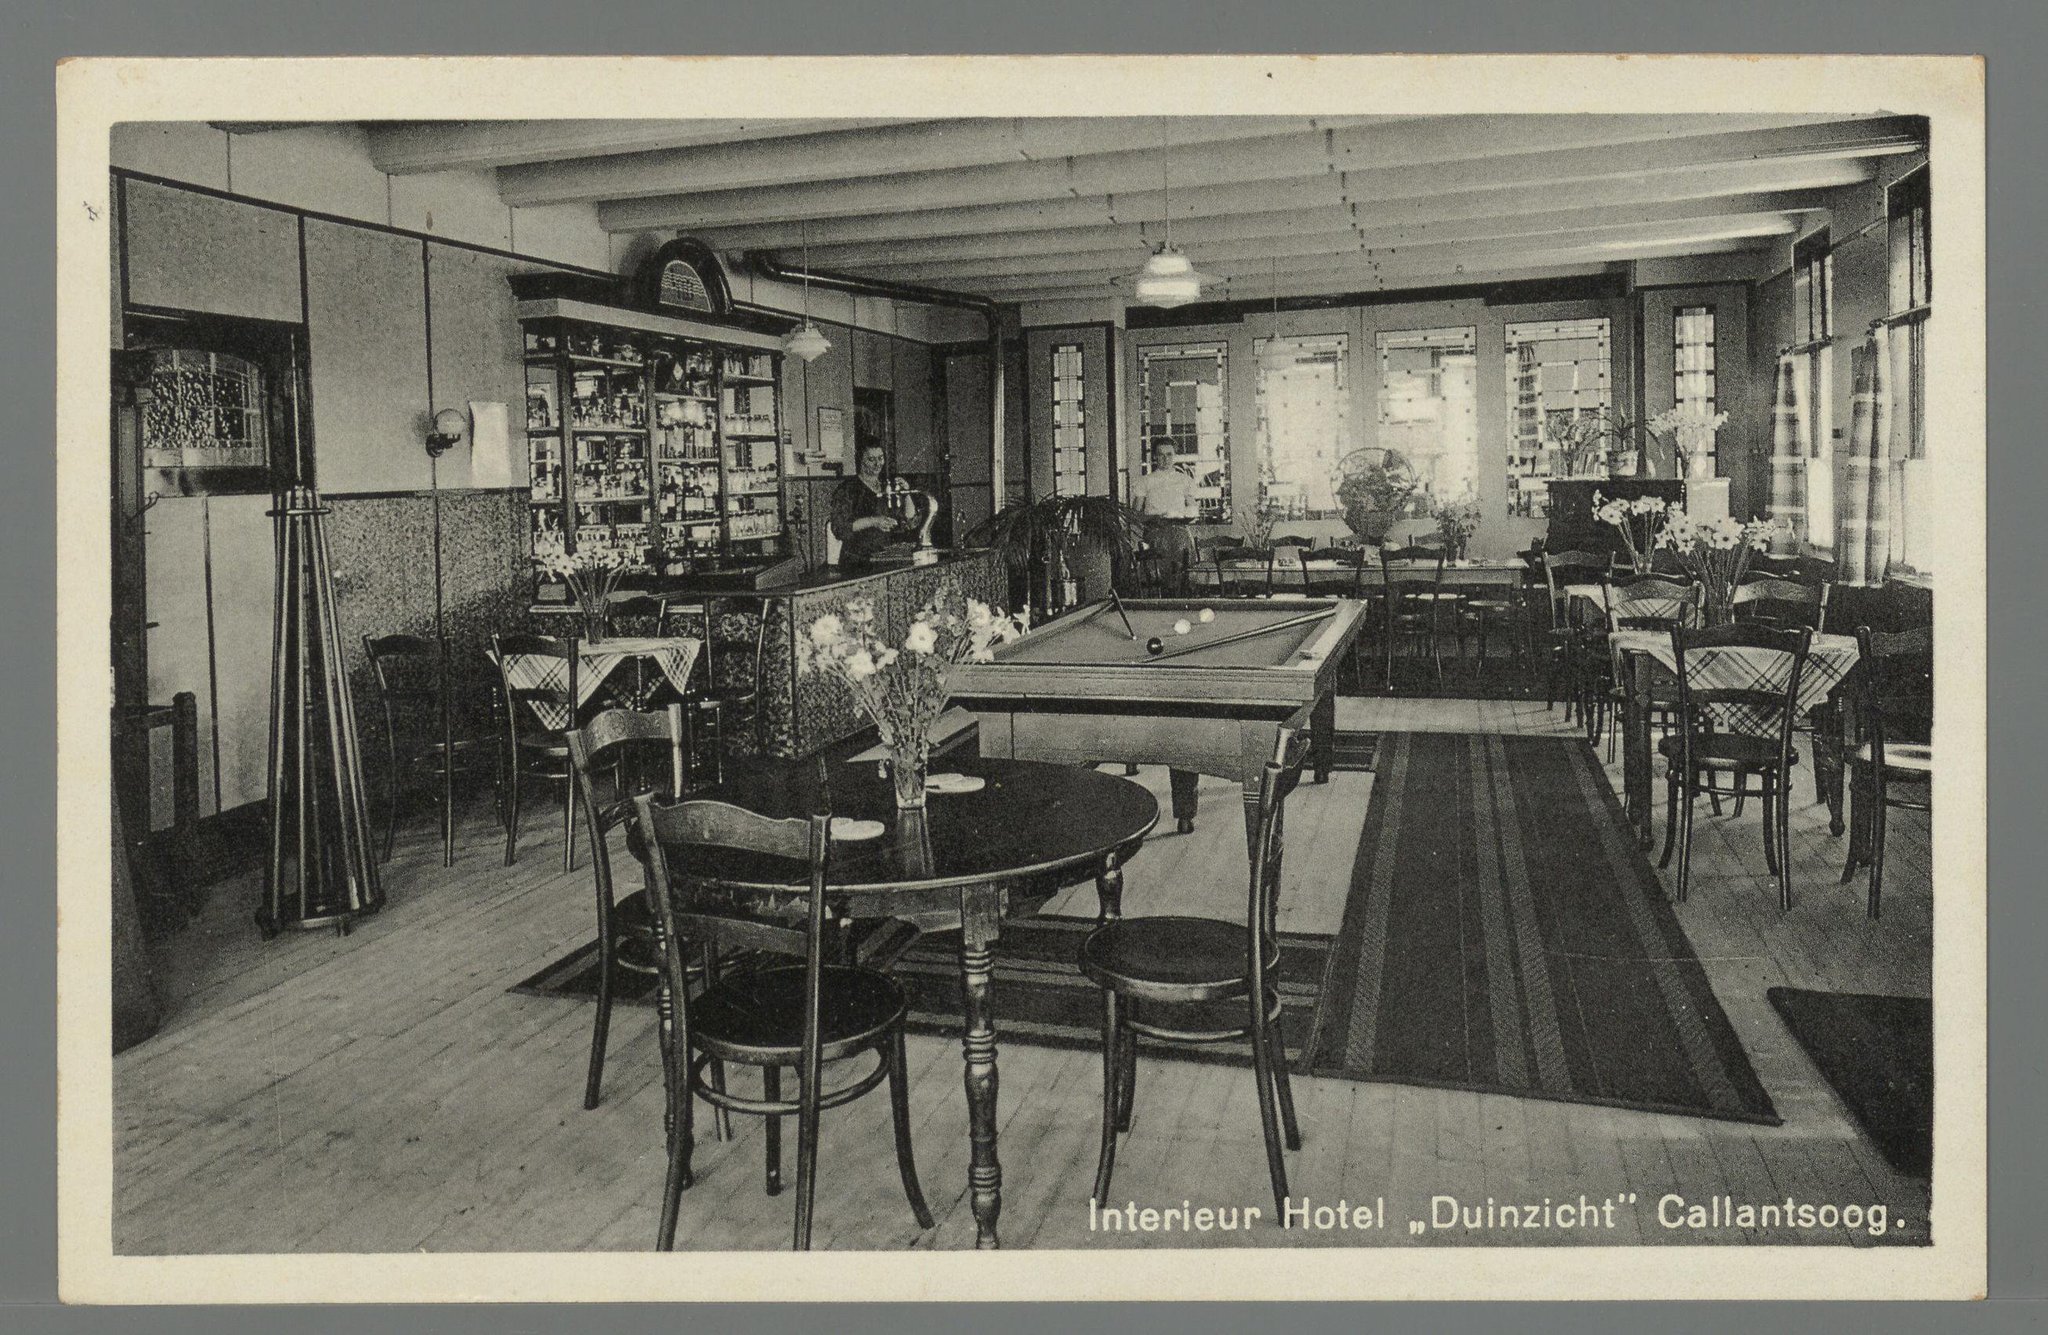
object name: photomechanical print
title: Interieur Hotel "Duinzicht" Callantsoog.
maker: Anonymous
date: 1913-1937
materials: cardboard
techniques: photograph, writing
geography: callantsoog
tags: city-view, and landscape with man-made constructions, interior of the house, hotel, hostelry, inn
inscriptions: postage stamp